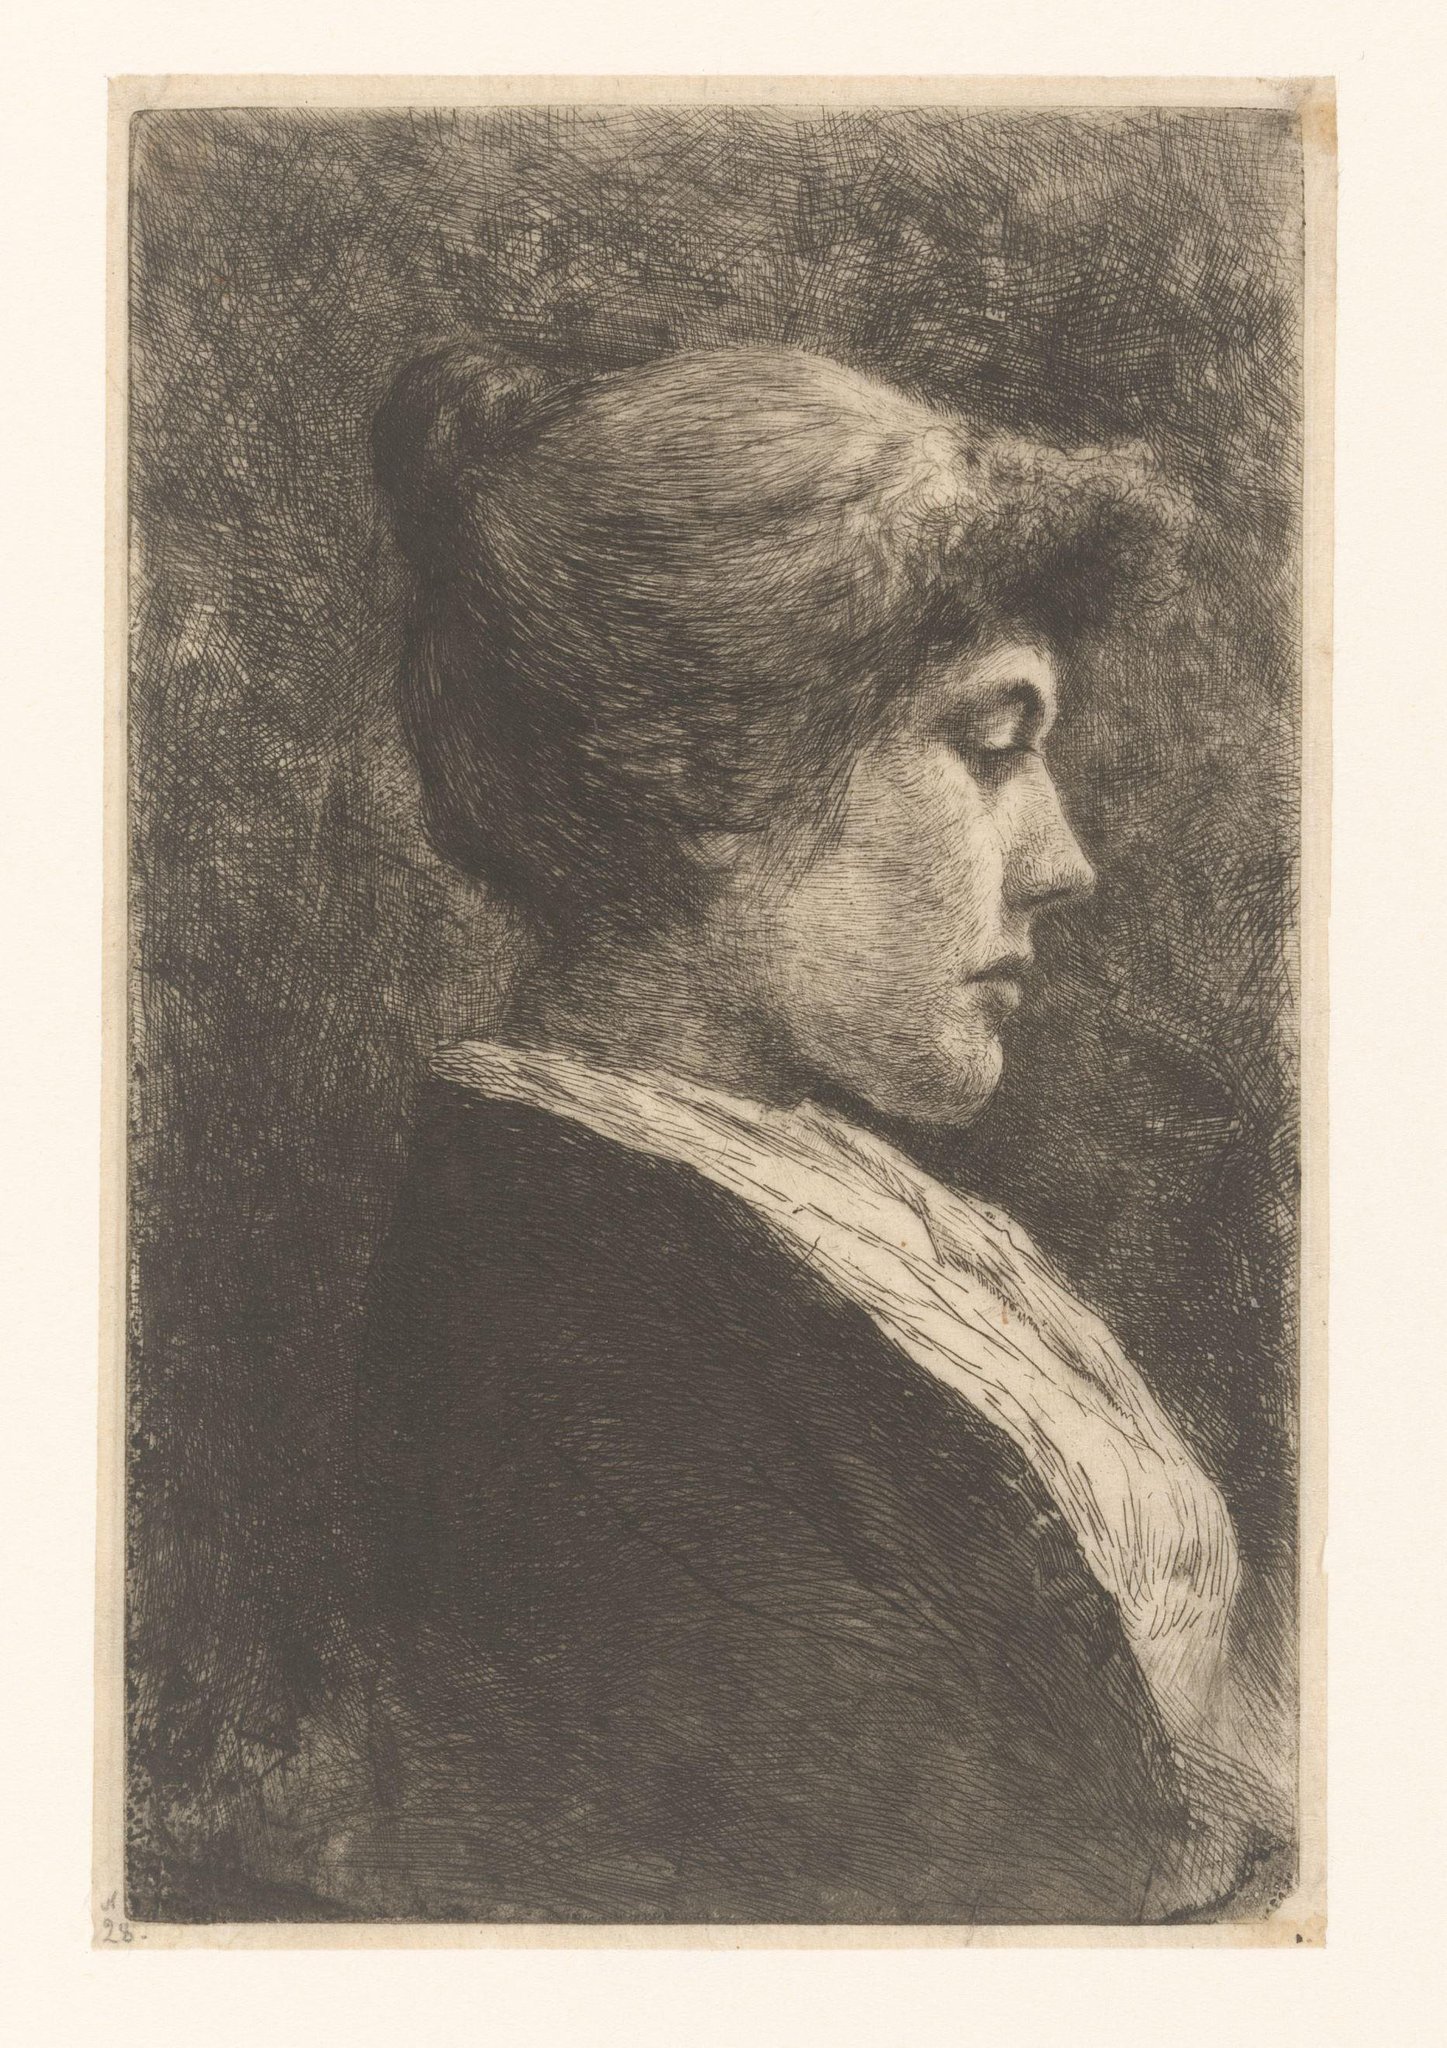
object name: print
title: Betsy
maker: philip zilcken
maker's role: draughtsman, painter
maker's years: 1857-1930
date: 1867-1890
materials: paper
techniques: drypoint, etching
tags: adult woman, historical persons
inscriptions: collector's mark: Lugt 2228